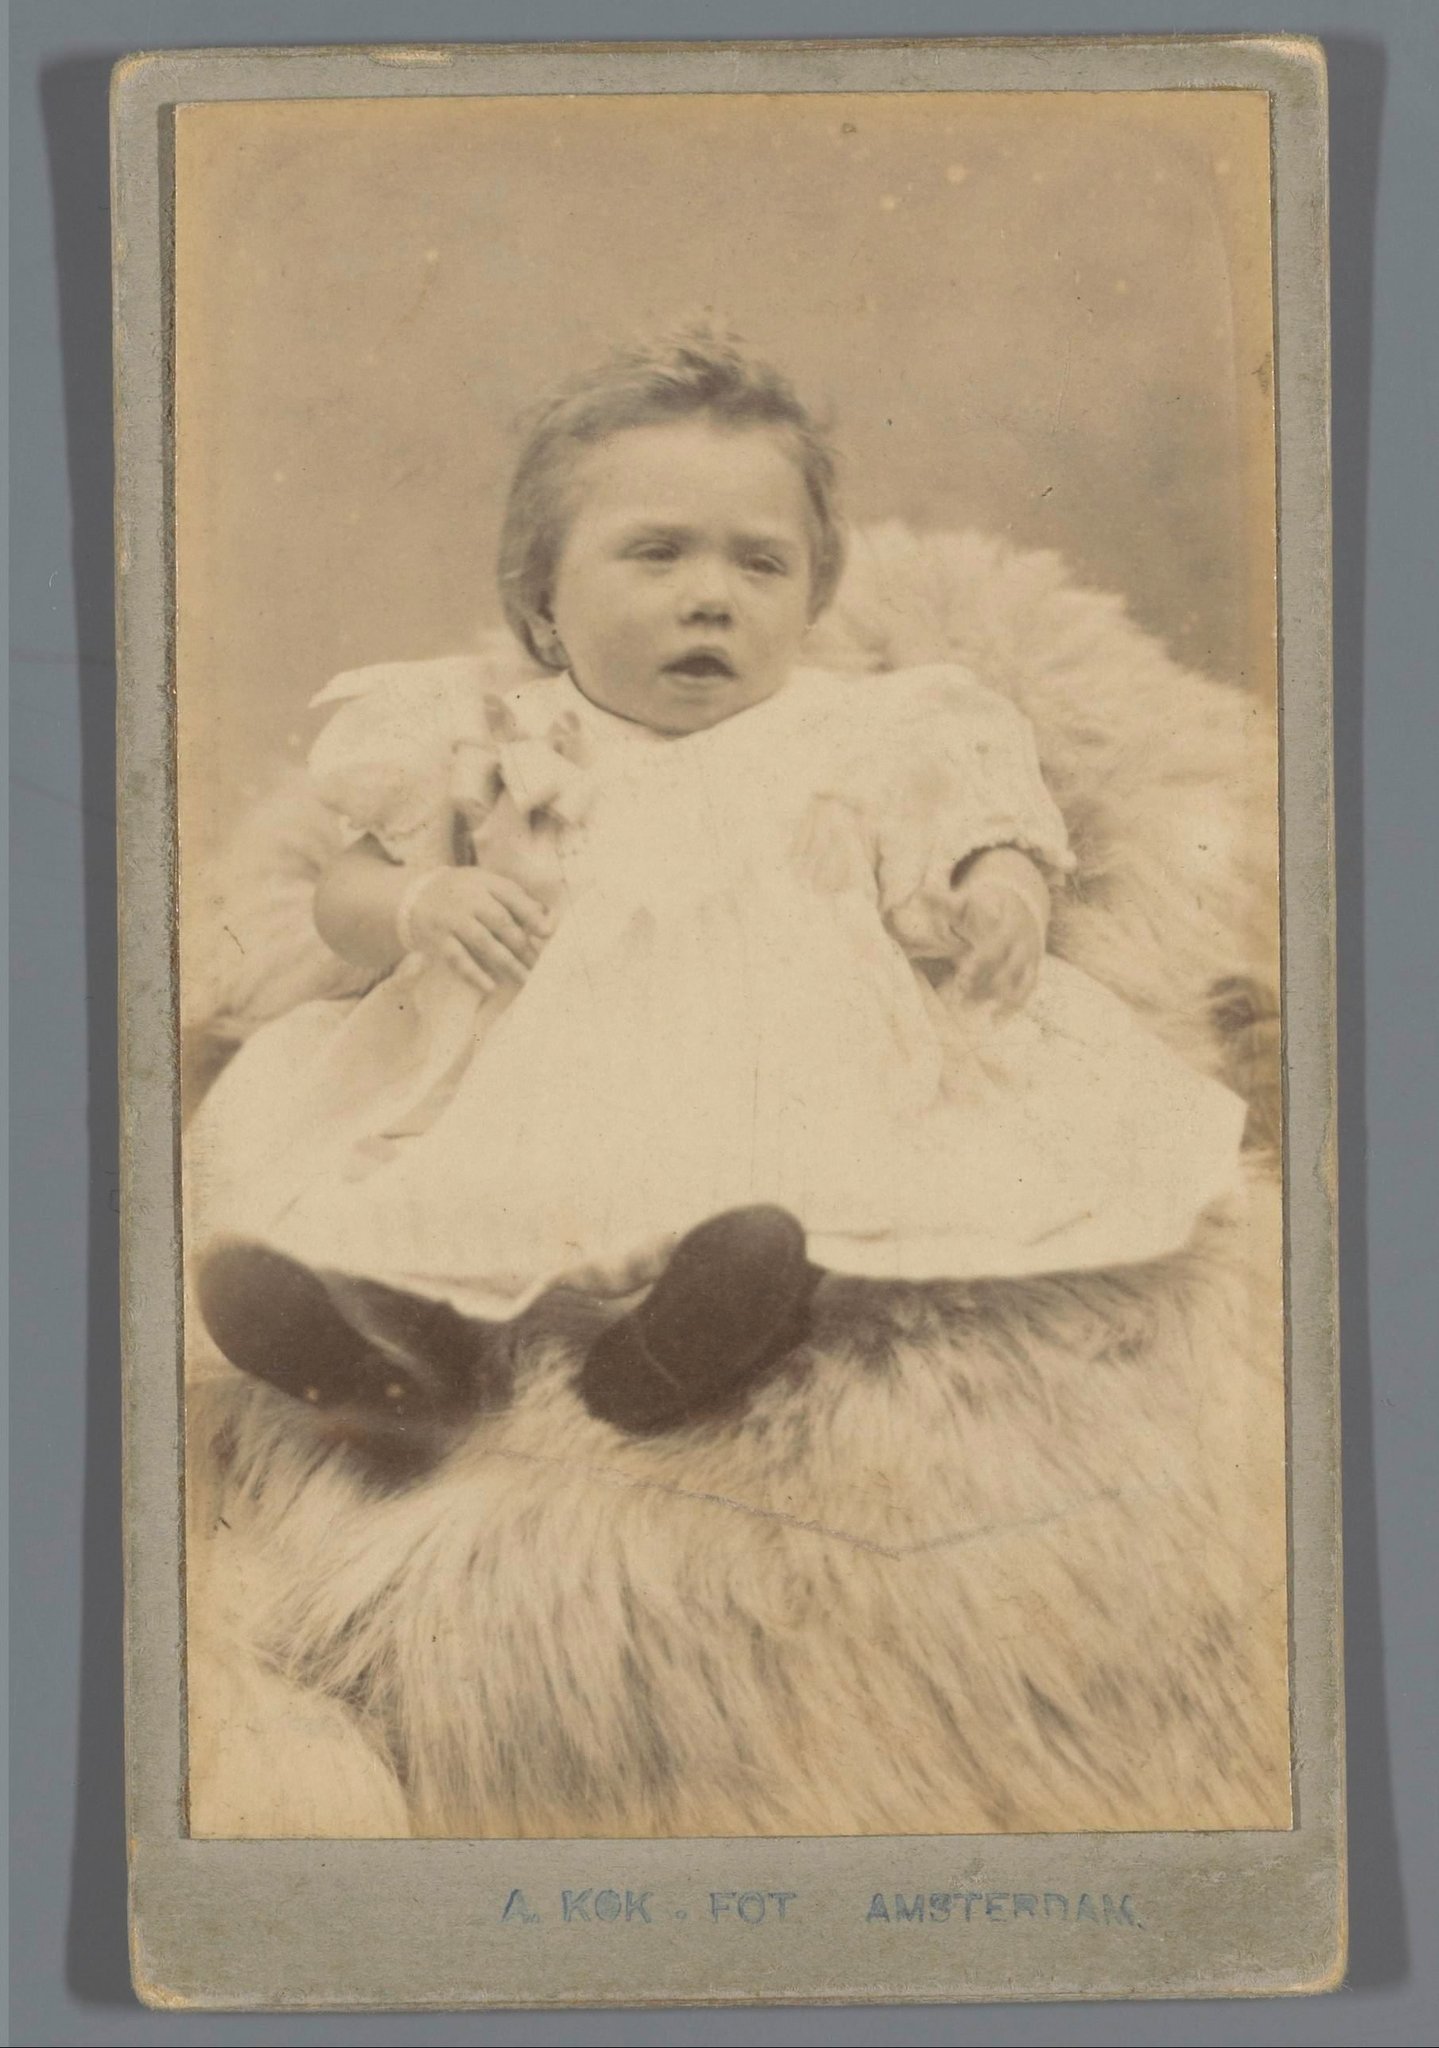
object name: photograph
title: Portret van een onbekende baby op een vacht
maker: adrianus kok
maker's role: fotograaf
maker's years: 1852-1916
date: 1884-1910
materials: cardboard, celluloid, paper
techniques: albumen print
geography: amsterdam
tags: anonymous historical person portrayed, infant, baby ~ the ages of man, amsterdam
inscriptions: inscription: ‘A. Kok. Fot. Amsterdam.’